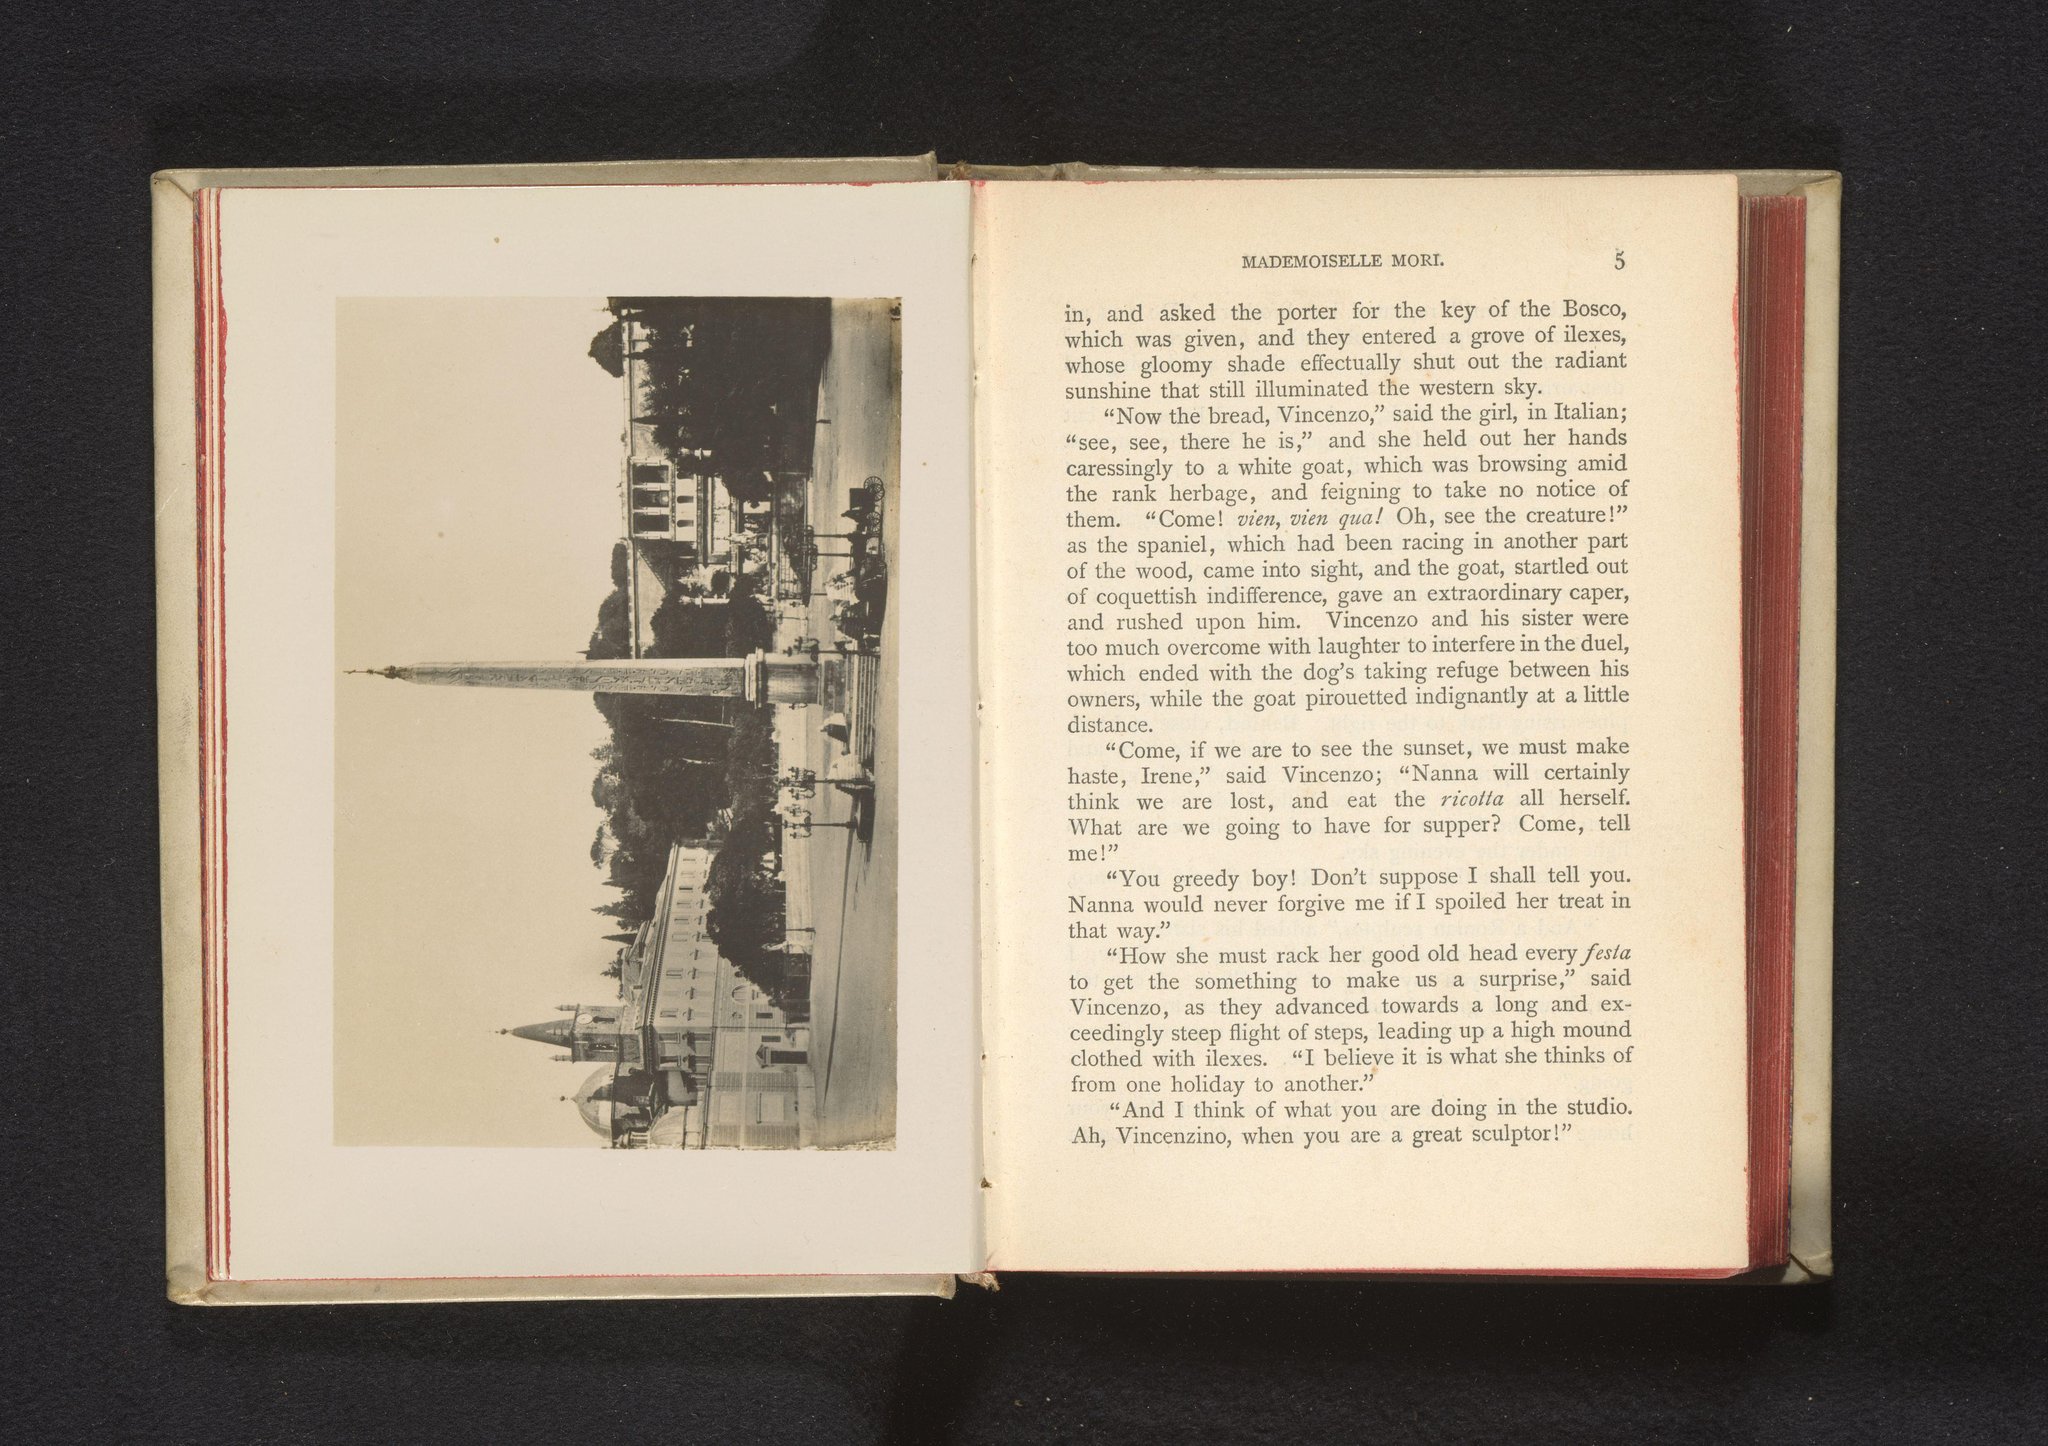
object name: photograph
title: Obelisk op het Piazza del Popolo te Rome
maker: Anonymous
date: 1852-1862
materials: photographic support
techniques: gelatin silver print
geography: piazza del popolo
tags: square, place, circus, etc., obelisk, needle